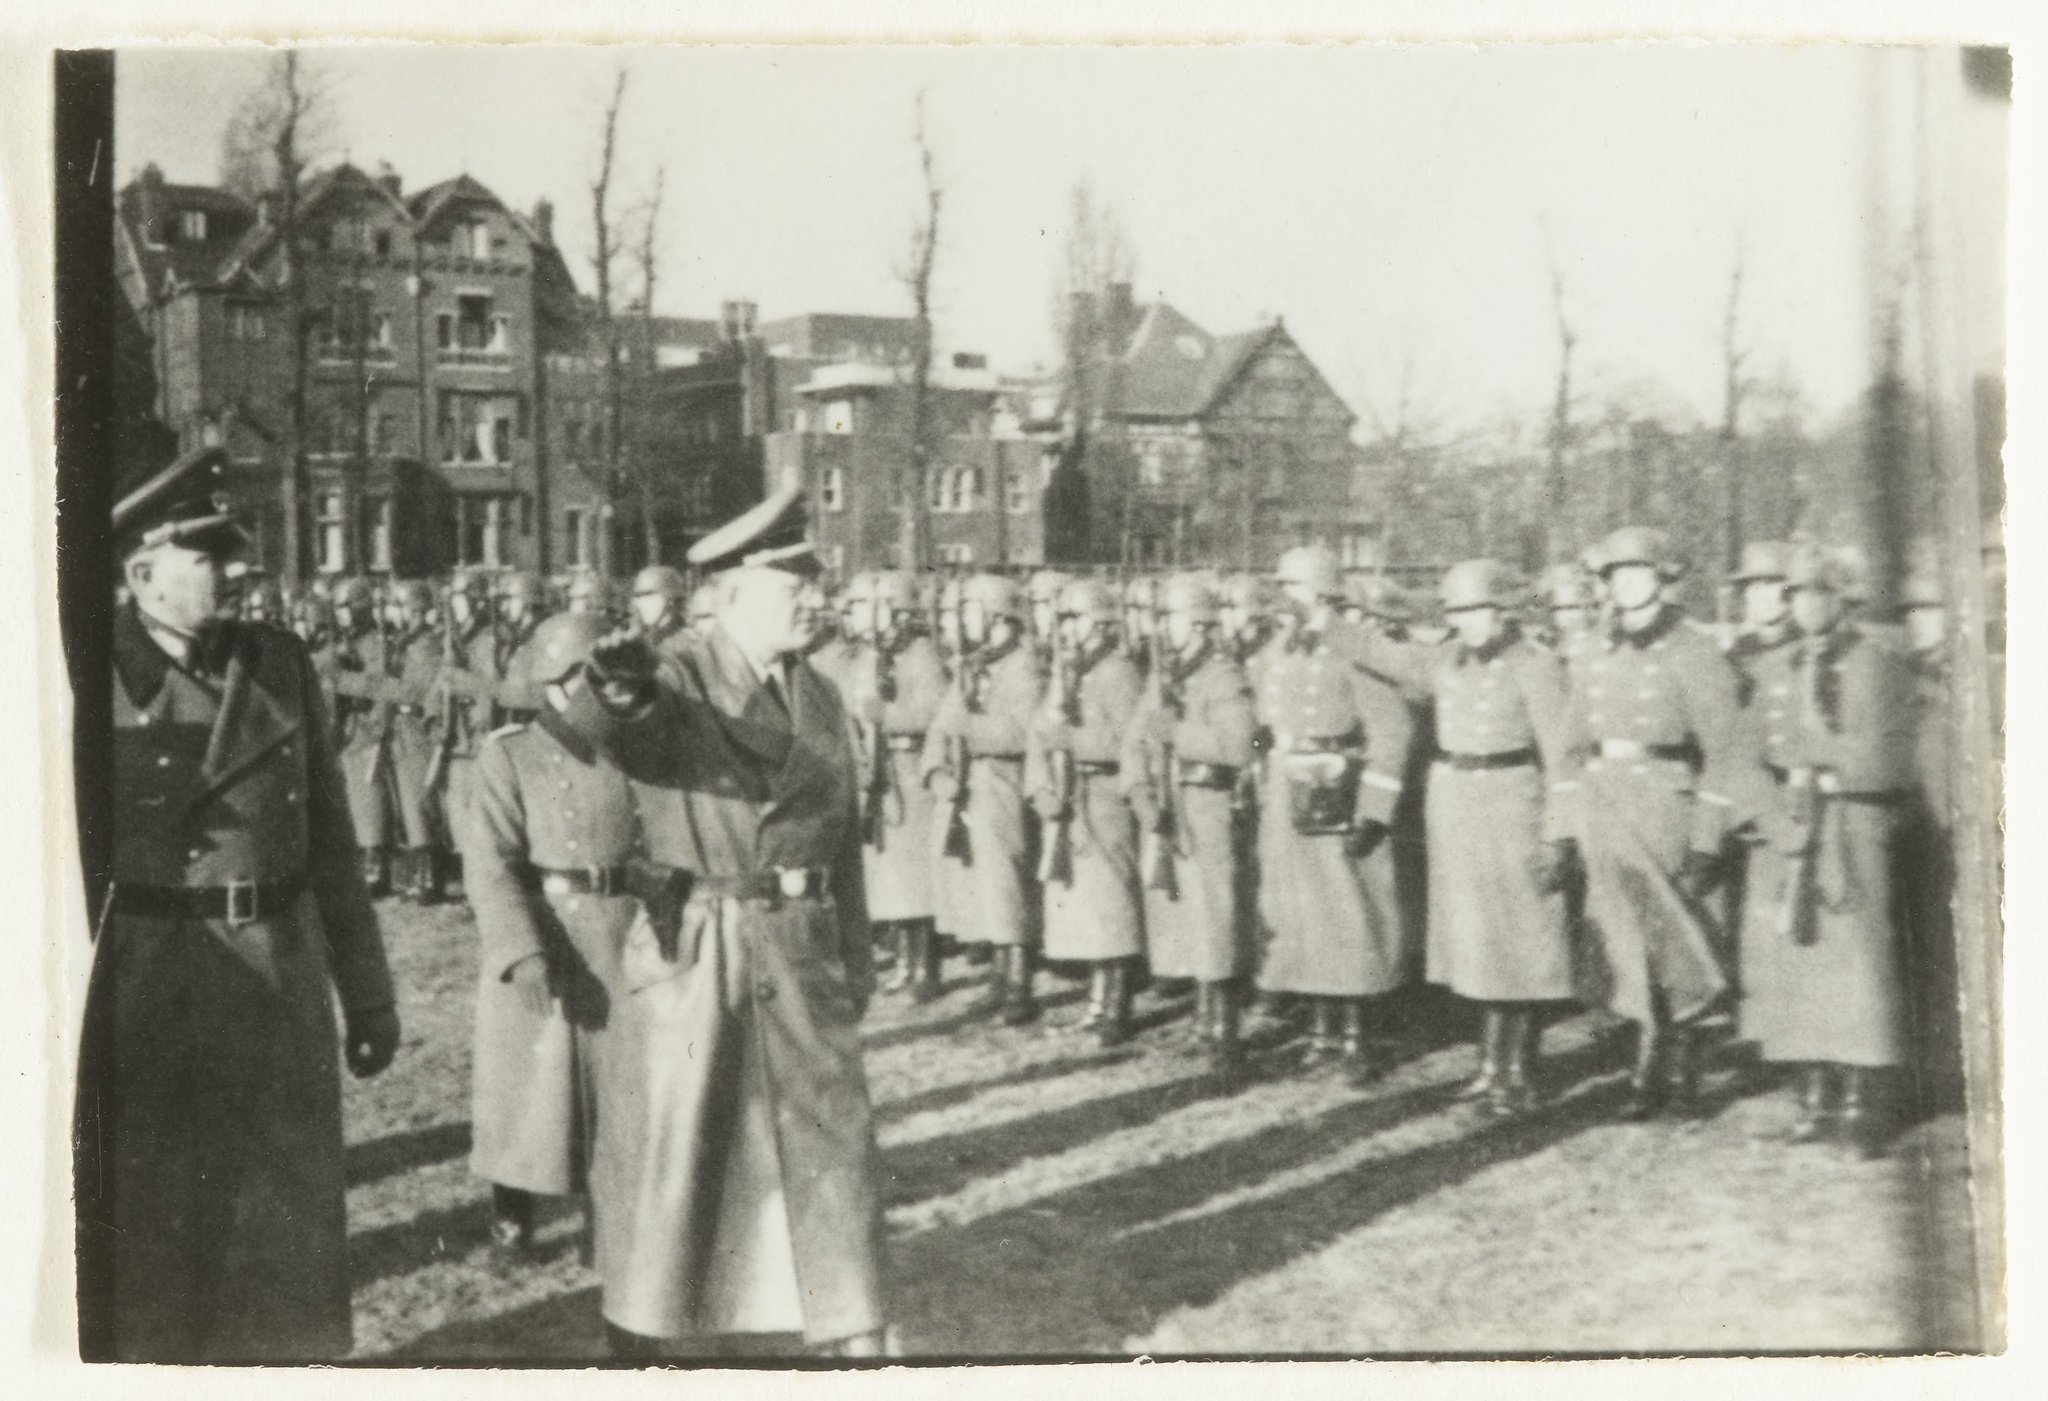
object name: contact print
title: NSB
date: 1940-1944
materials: photographic support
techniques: photography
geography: netherlands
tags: politician, arthur seyss-inquart, review, inspection (of company, unit, troop), netherlands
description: Een rij Duitse militairen staat in het gelid in een stad. Hoge Duitse militairen lopen langs hen, een brengt de Hitlergroet. Deze is waarschijnlijk Seyss-Inquart.